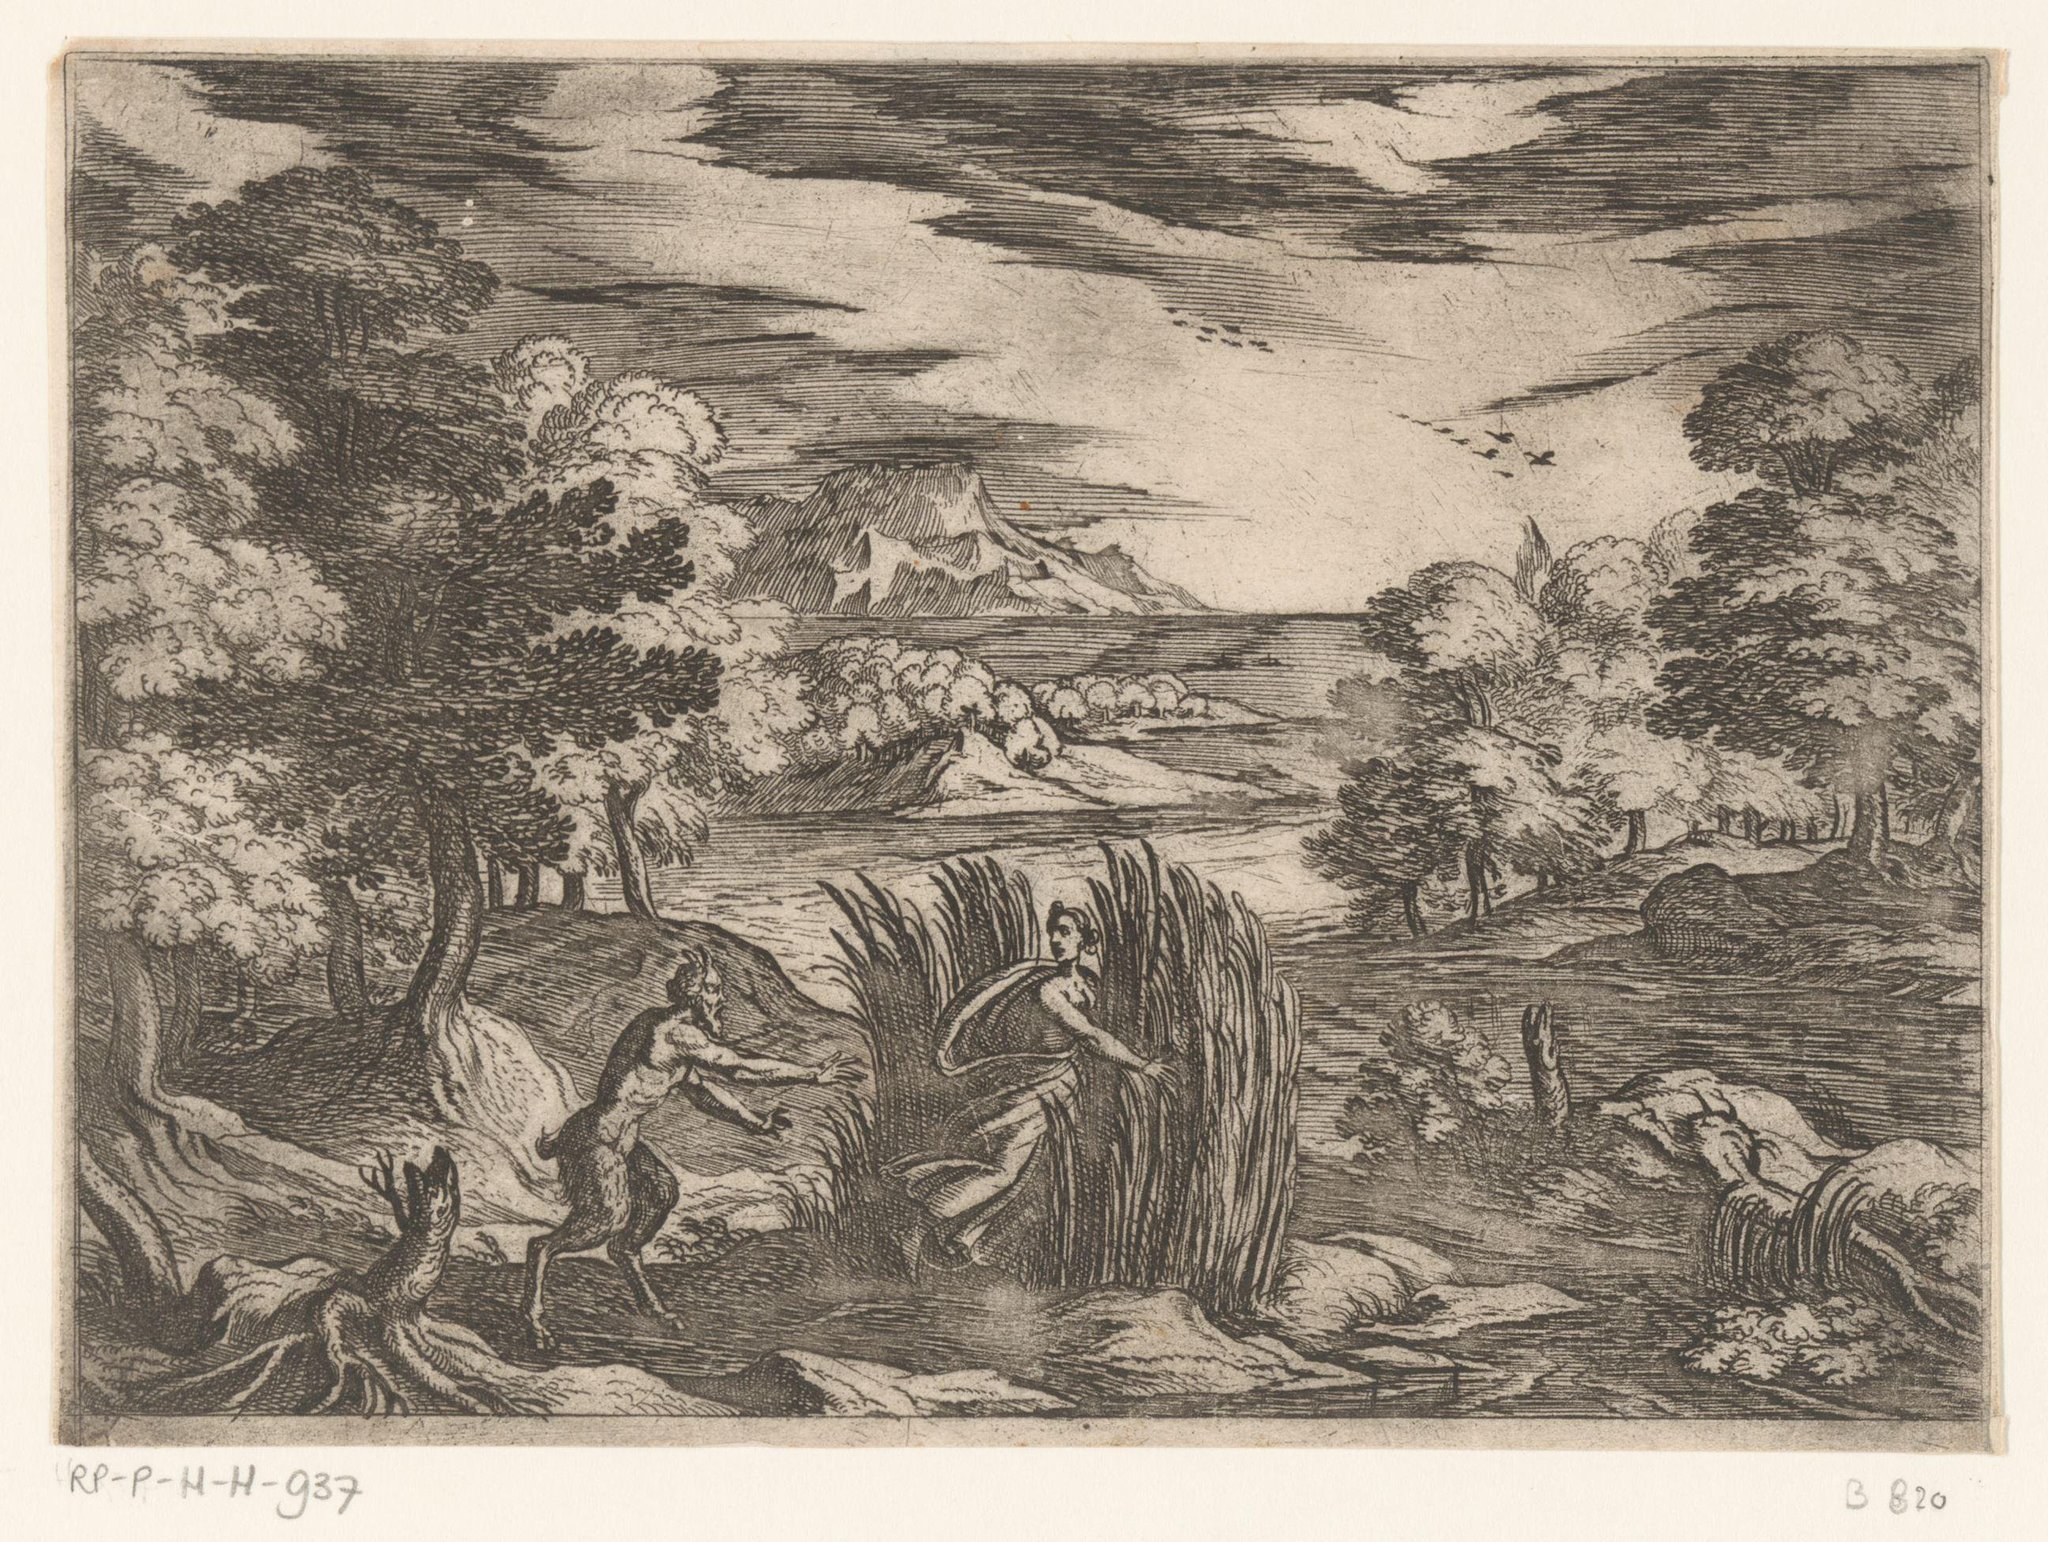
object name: print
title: Landschappen met mythologische scènes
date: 1565-1630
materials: paper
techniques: etching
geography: italy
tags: landscapes - hh - ideal landscapes, syrinx changed into a reed: while fleeing from pan, the nymph syrinx is changed into reed by her sisters, the naiads (ovid, metamorphoses i 705)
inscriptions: collector's mark: ‘Hinloopen’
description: In een weids landschap met bomen en zee achtervolgt Pan de nimf Syrinx uit Arcadië. Syrinx verandert in riet.